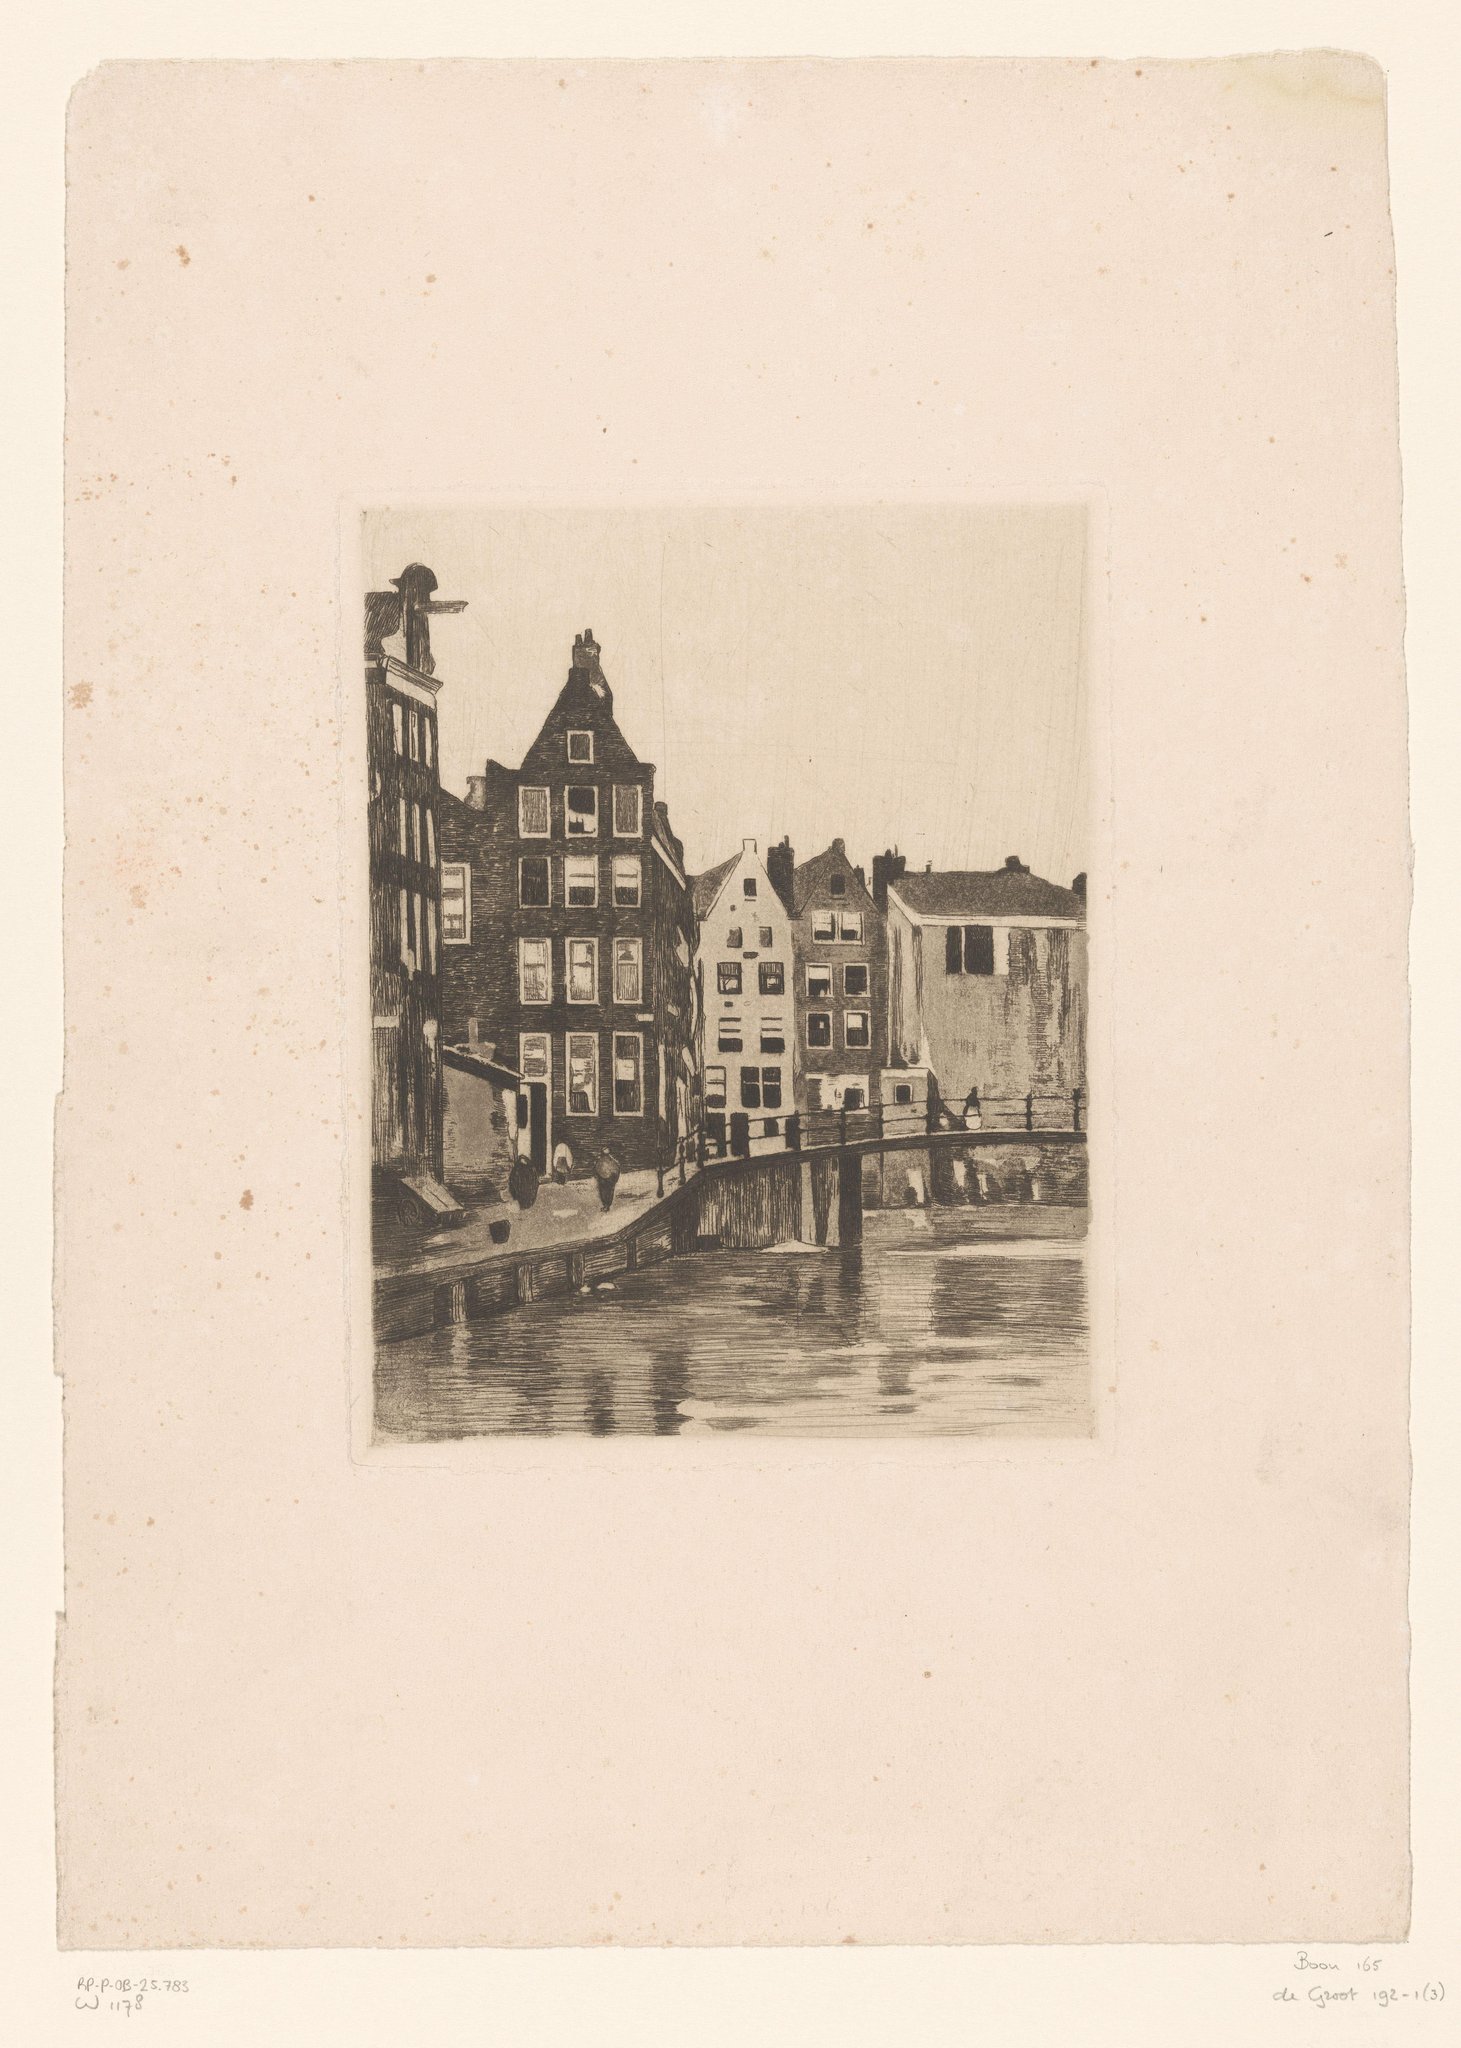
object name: print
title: Gezicht op huizen en een brug in Amsterdam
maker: willem witsen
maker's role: draughtsman, painter, print maker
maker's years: 1860-1923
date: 1915-1919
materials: paper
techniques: aquatint, etching, intaglio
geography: amsterdam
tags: urban housing, canals, waters (in city), bridge, amsterdam